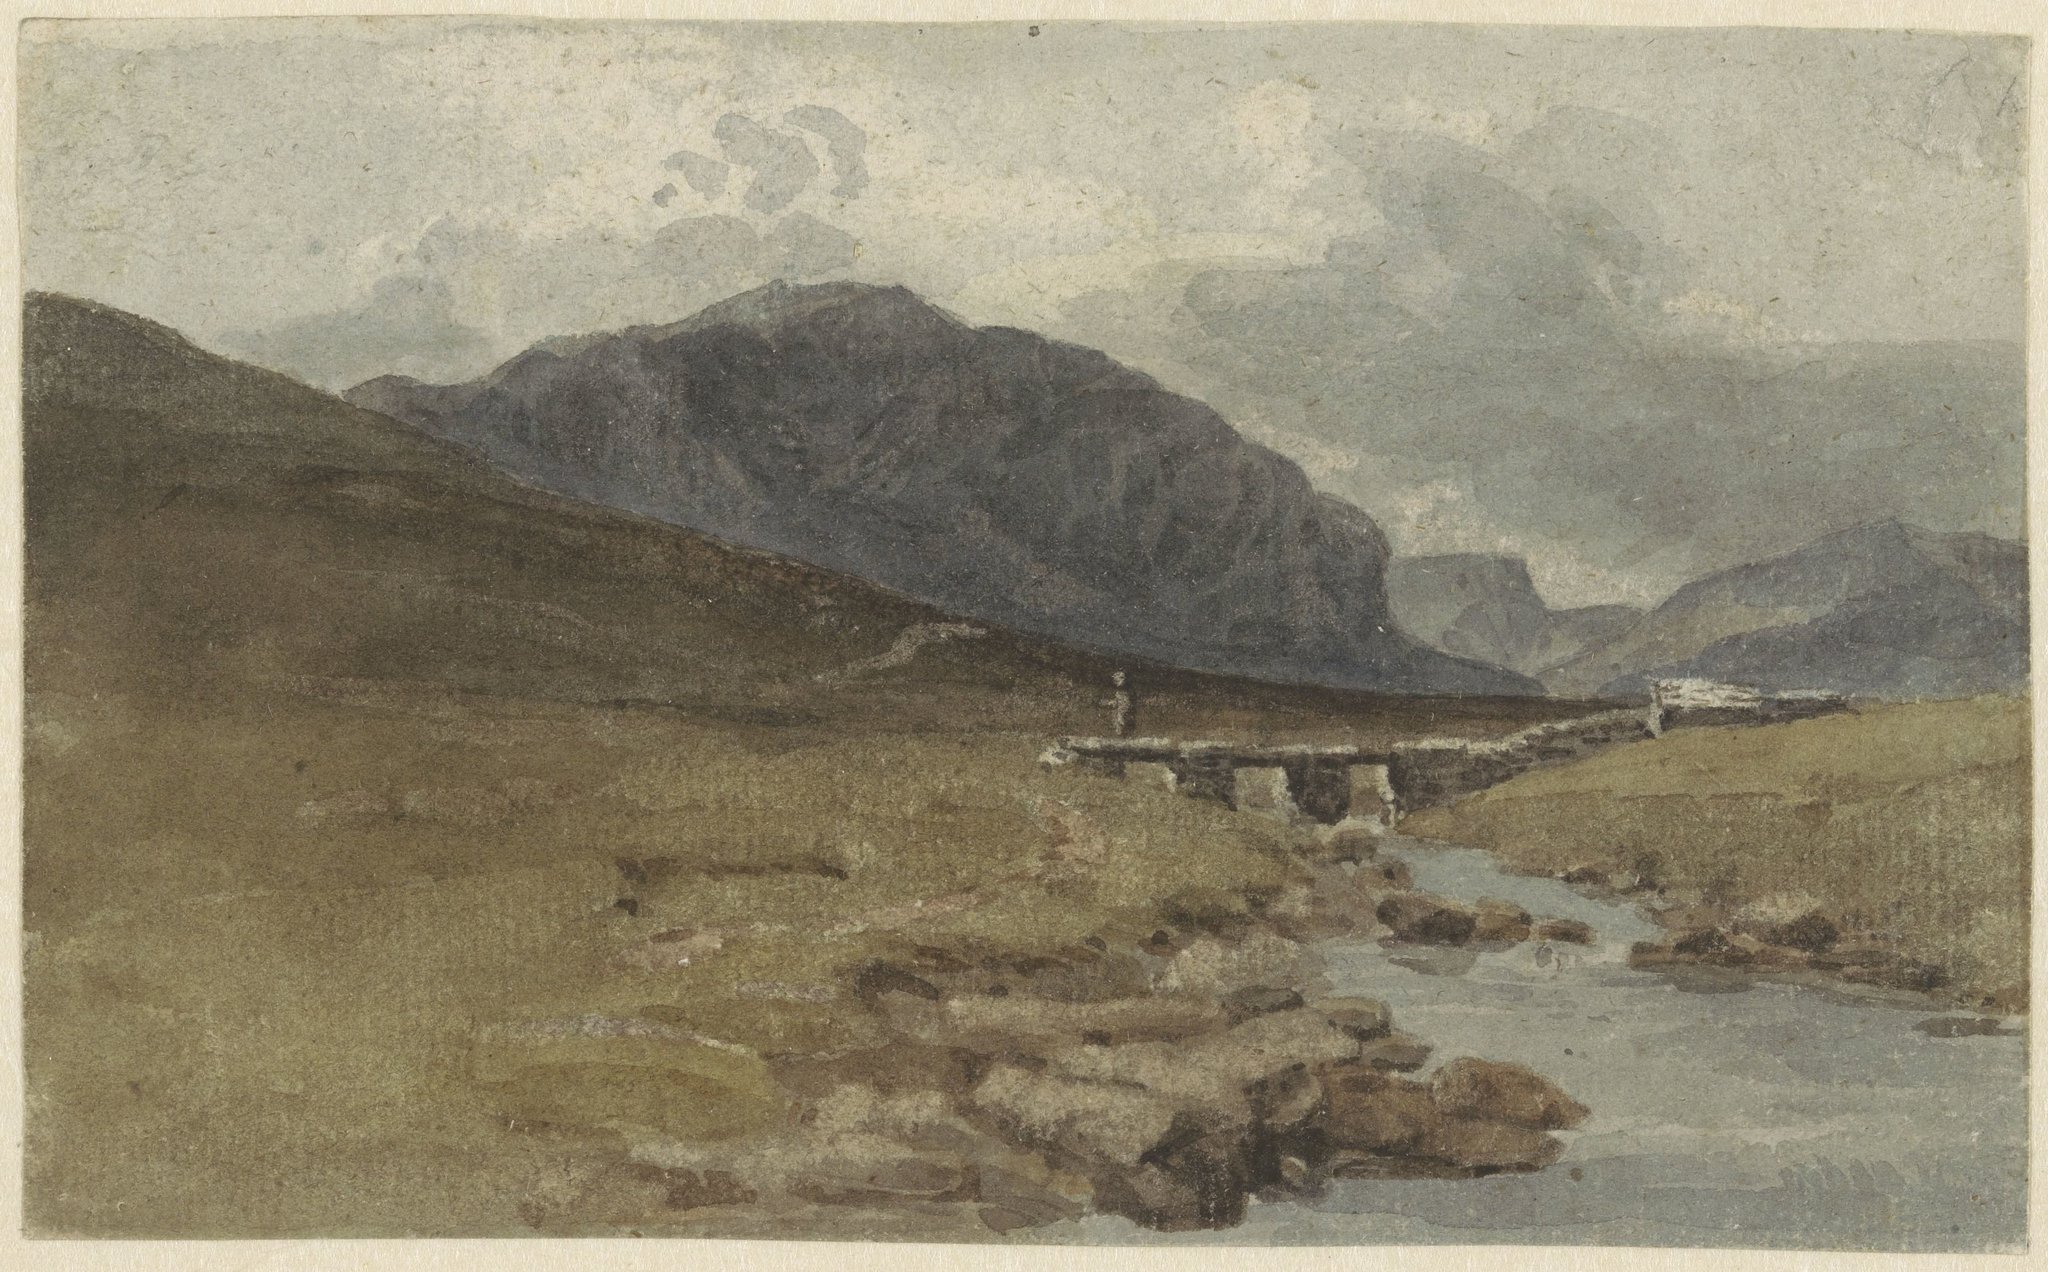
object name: watercolor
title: Landschap bij Llyn Ogwen, Caernarvonshire (Wales)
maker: joshua cristall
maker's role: painter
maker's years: 1768-1847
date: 1778-1847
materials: paper, watercolor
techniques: brush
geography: caernarvonshire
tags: llyn ogwen, caernarvonshire